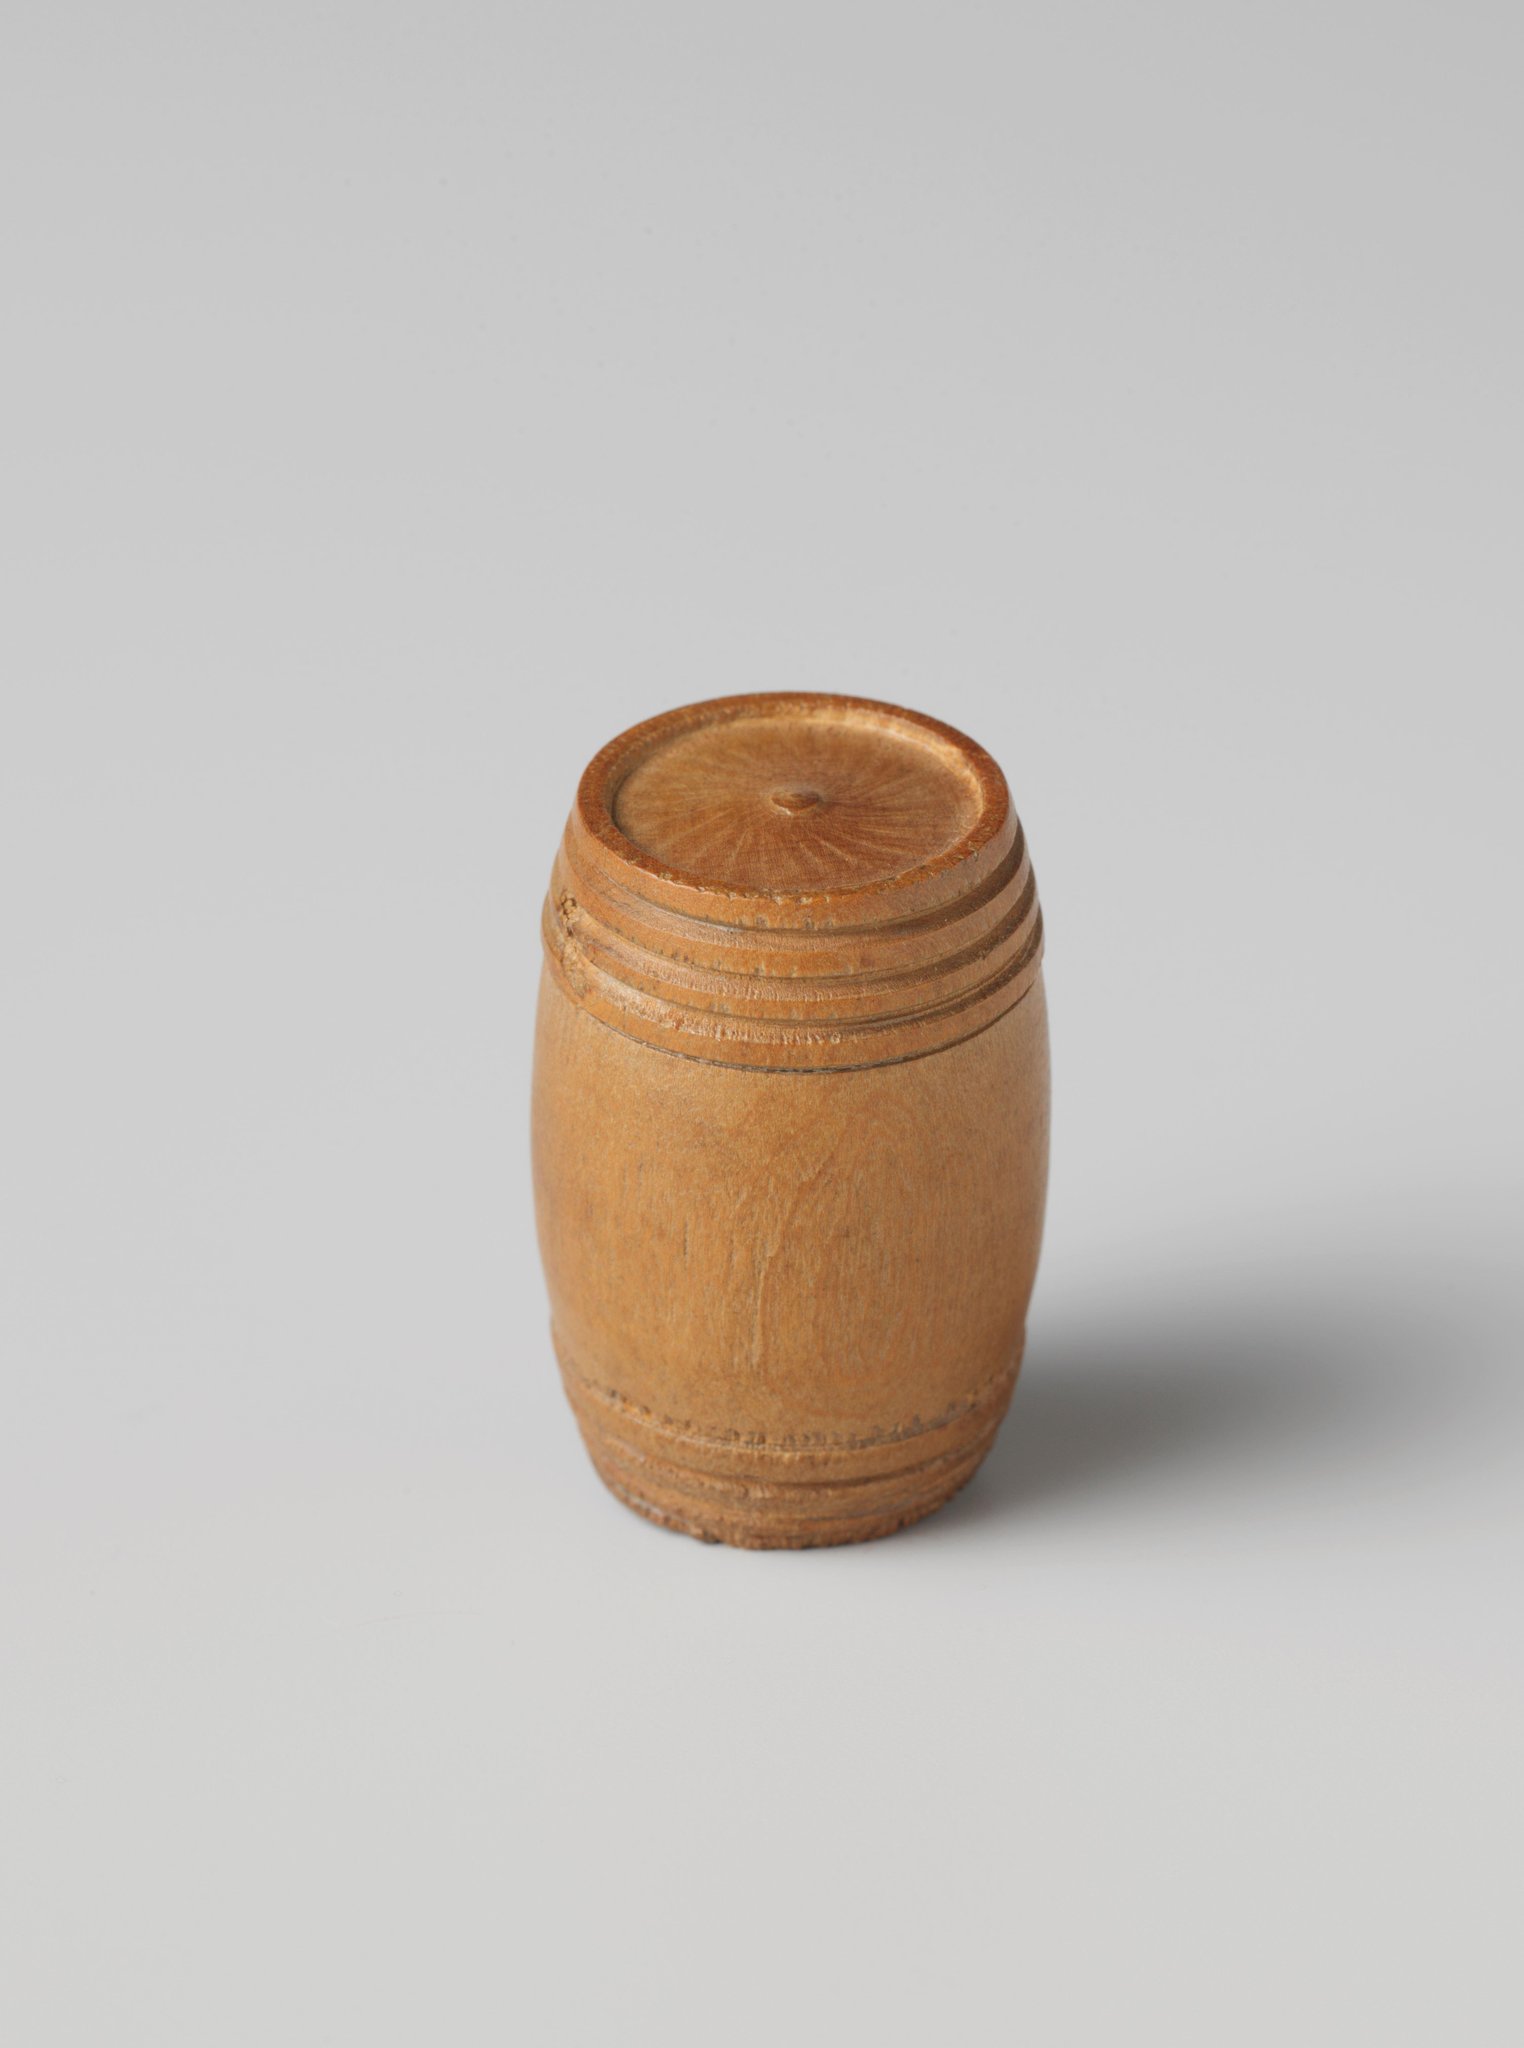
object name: miniature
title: Vat van gedraaid, massief hout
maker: Anonymous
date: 1700-1799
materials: wood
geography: amsterdam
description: Een vat gedraaid van massief esdoornhout.